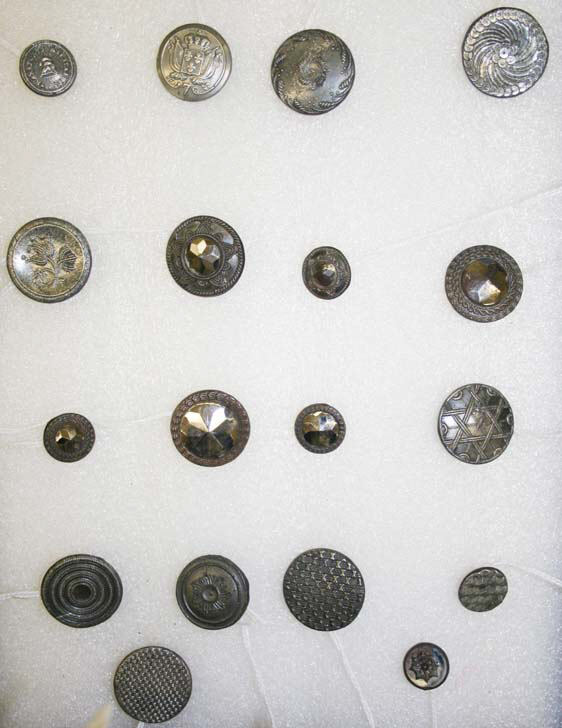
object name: button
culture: french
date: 1780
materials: bone, metal, wood